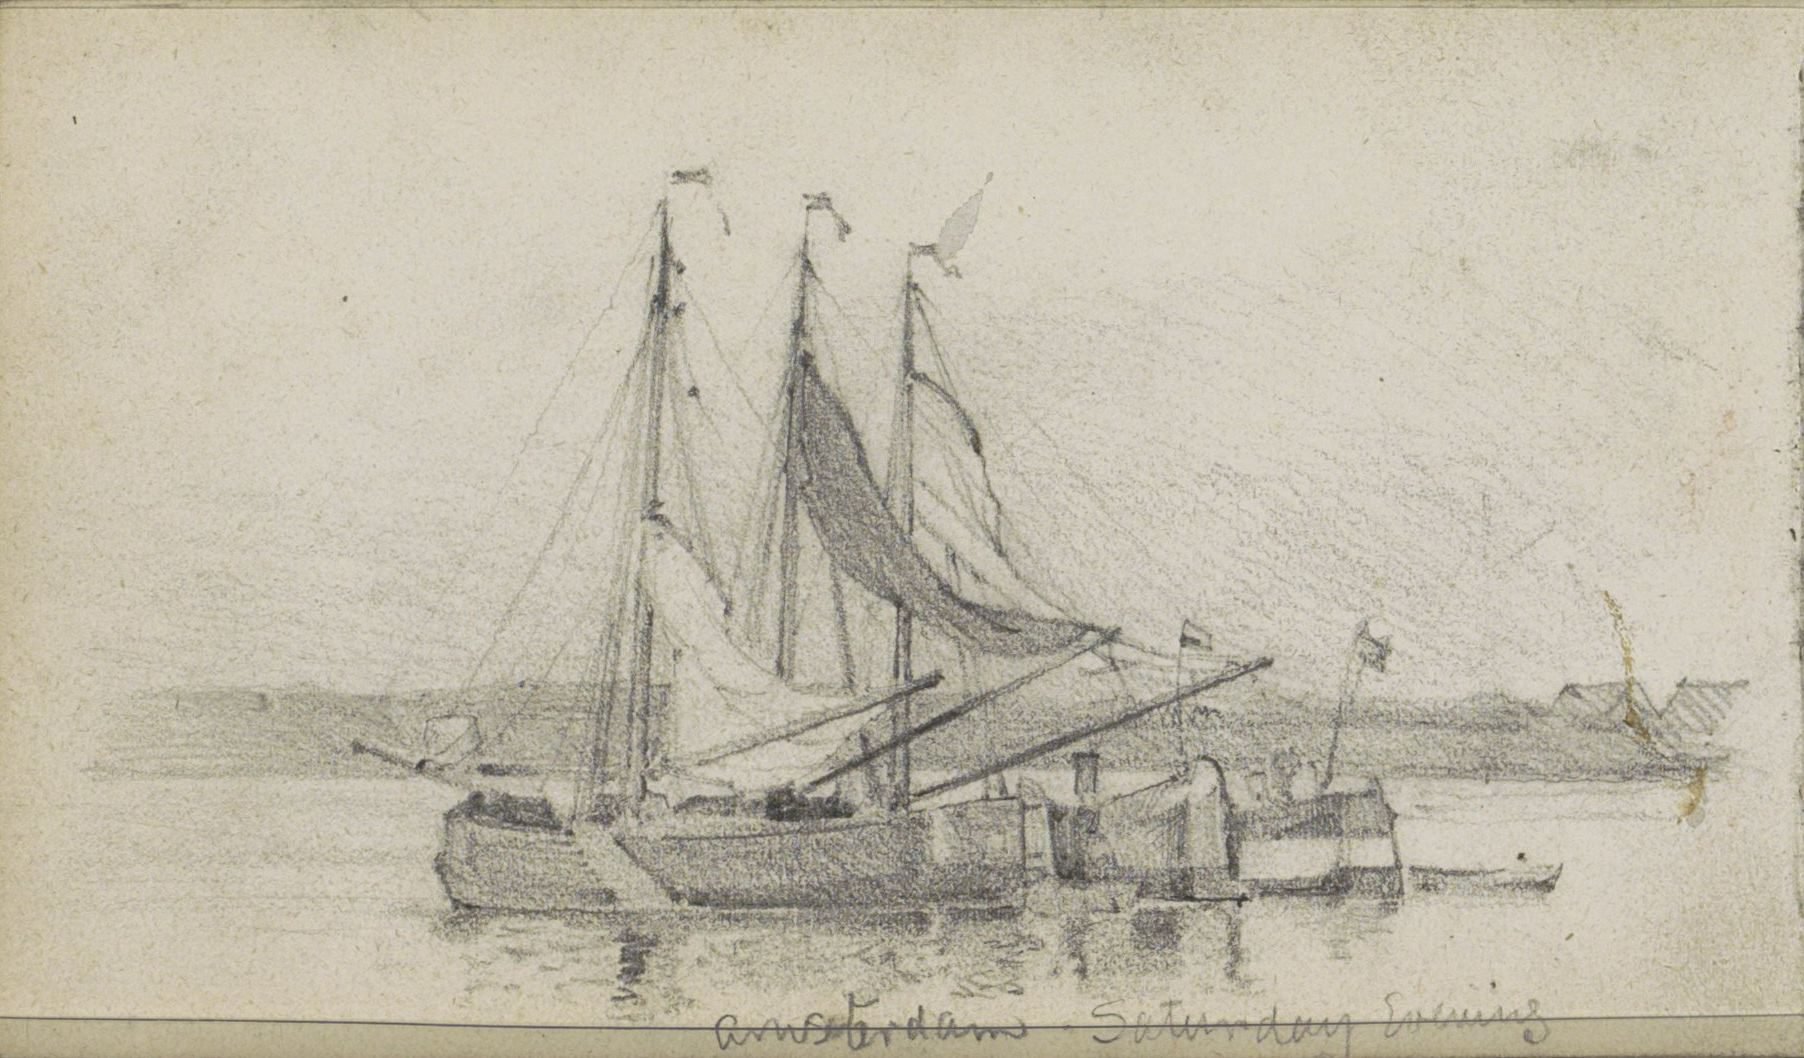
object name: sketchbook leaf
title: Zeilschepen op het water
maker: george clausen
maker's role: draughtsman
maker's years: 1852-1912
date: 1875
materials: paper, pencil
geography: amsterdam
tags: sailing-ship, sailing-boat, landscapes with waters, waterscapes, seascapes (in the temperate zone), amsterdam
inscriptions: annotation: ‘amsterdam . Saturday Evening’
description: Blad 21 verso uit een schetsboek met 46 bladen.